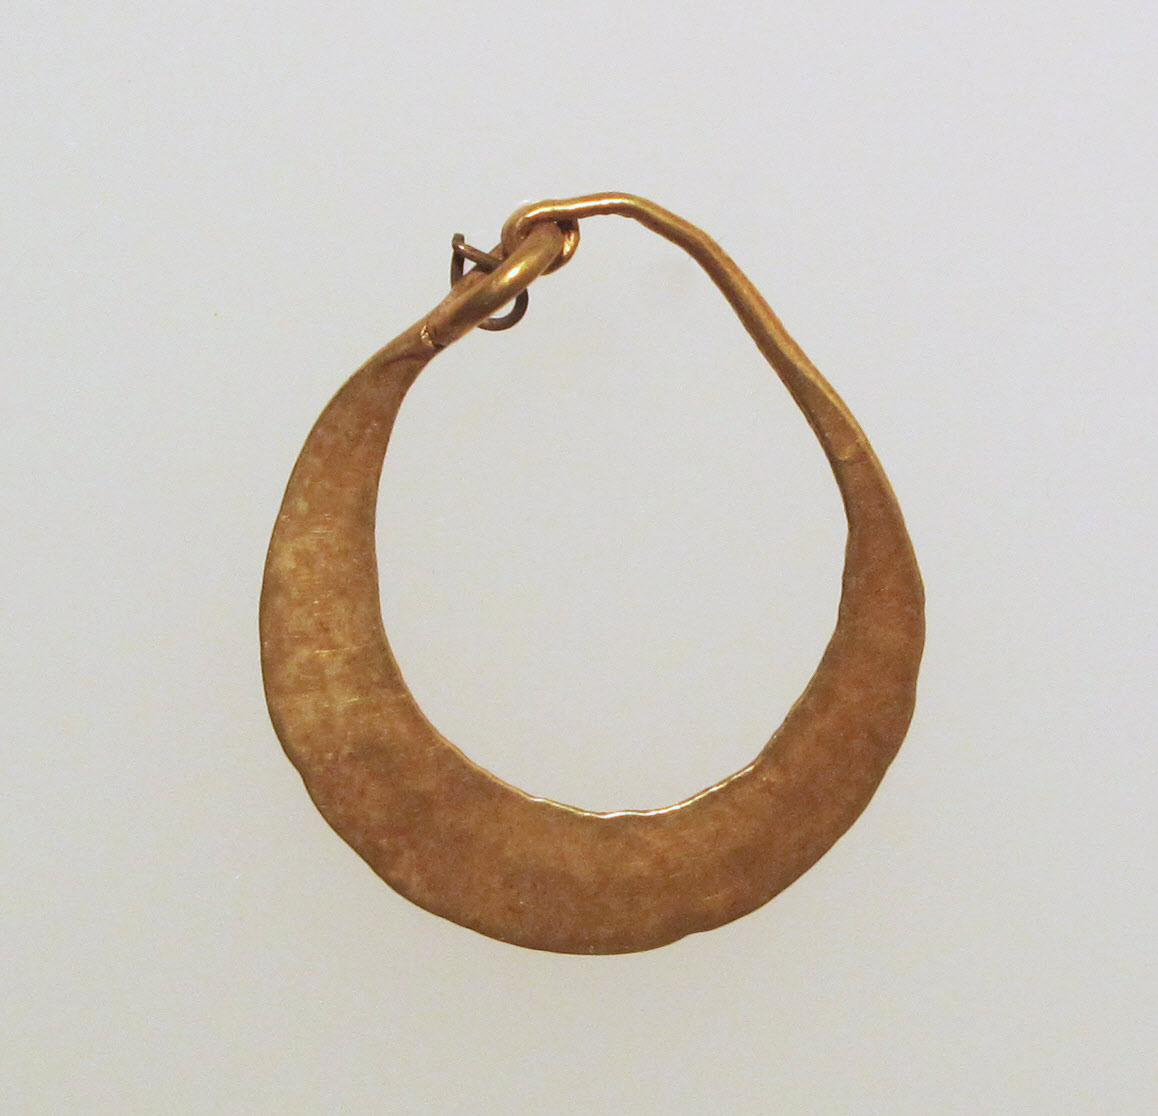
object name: earring, crescent shaped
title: Earring, crescent-shaped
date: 7000 BCE-330 CE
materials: gold